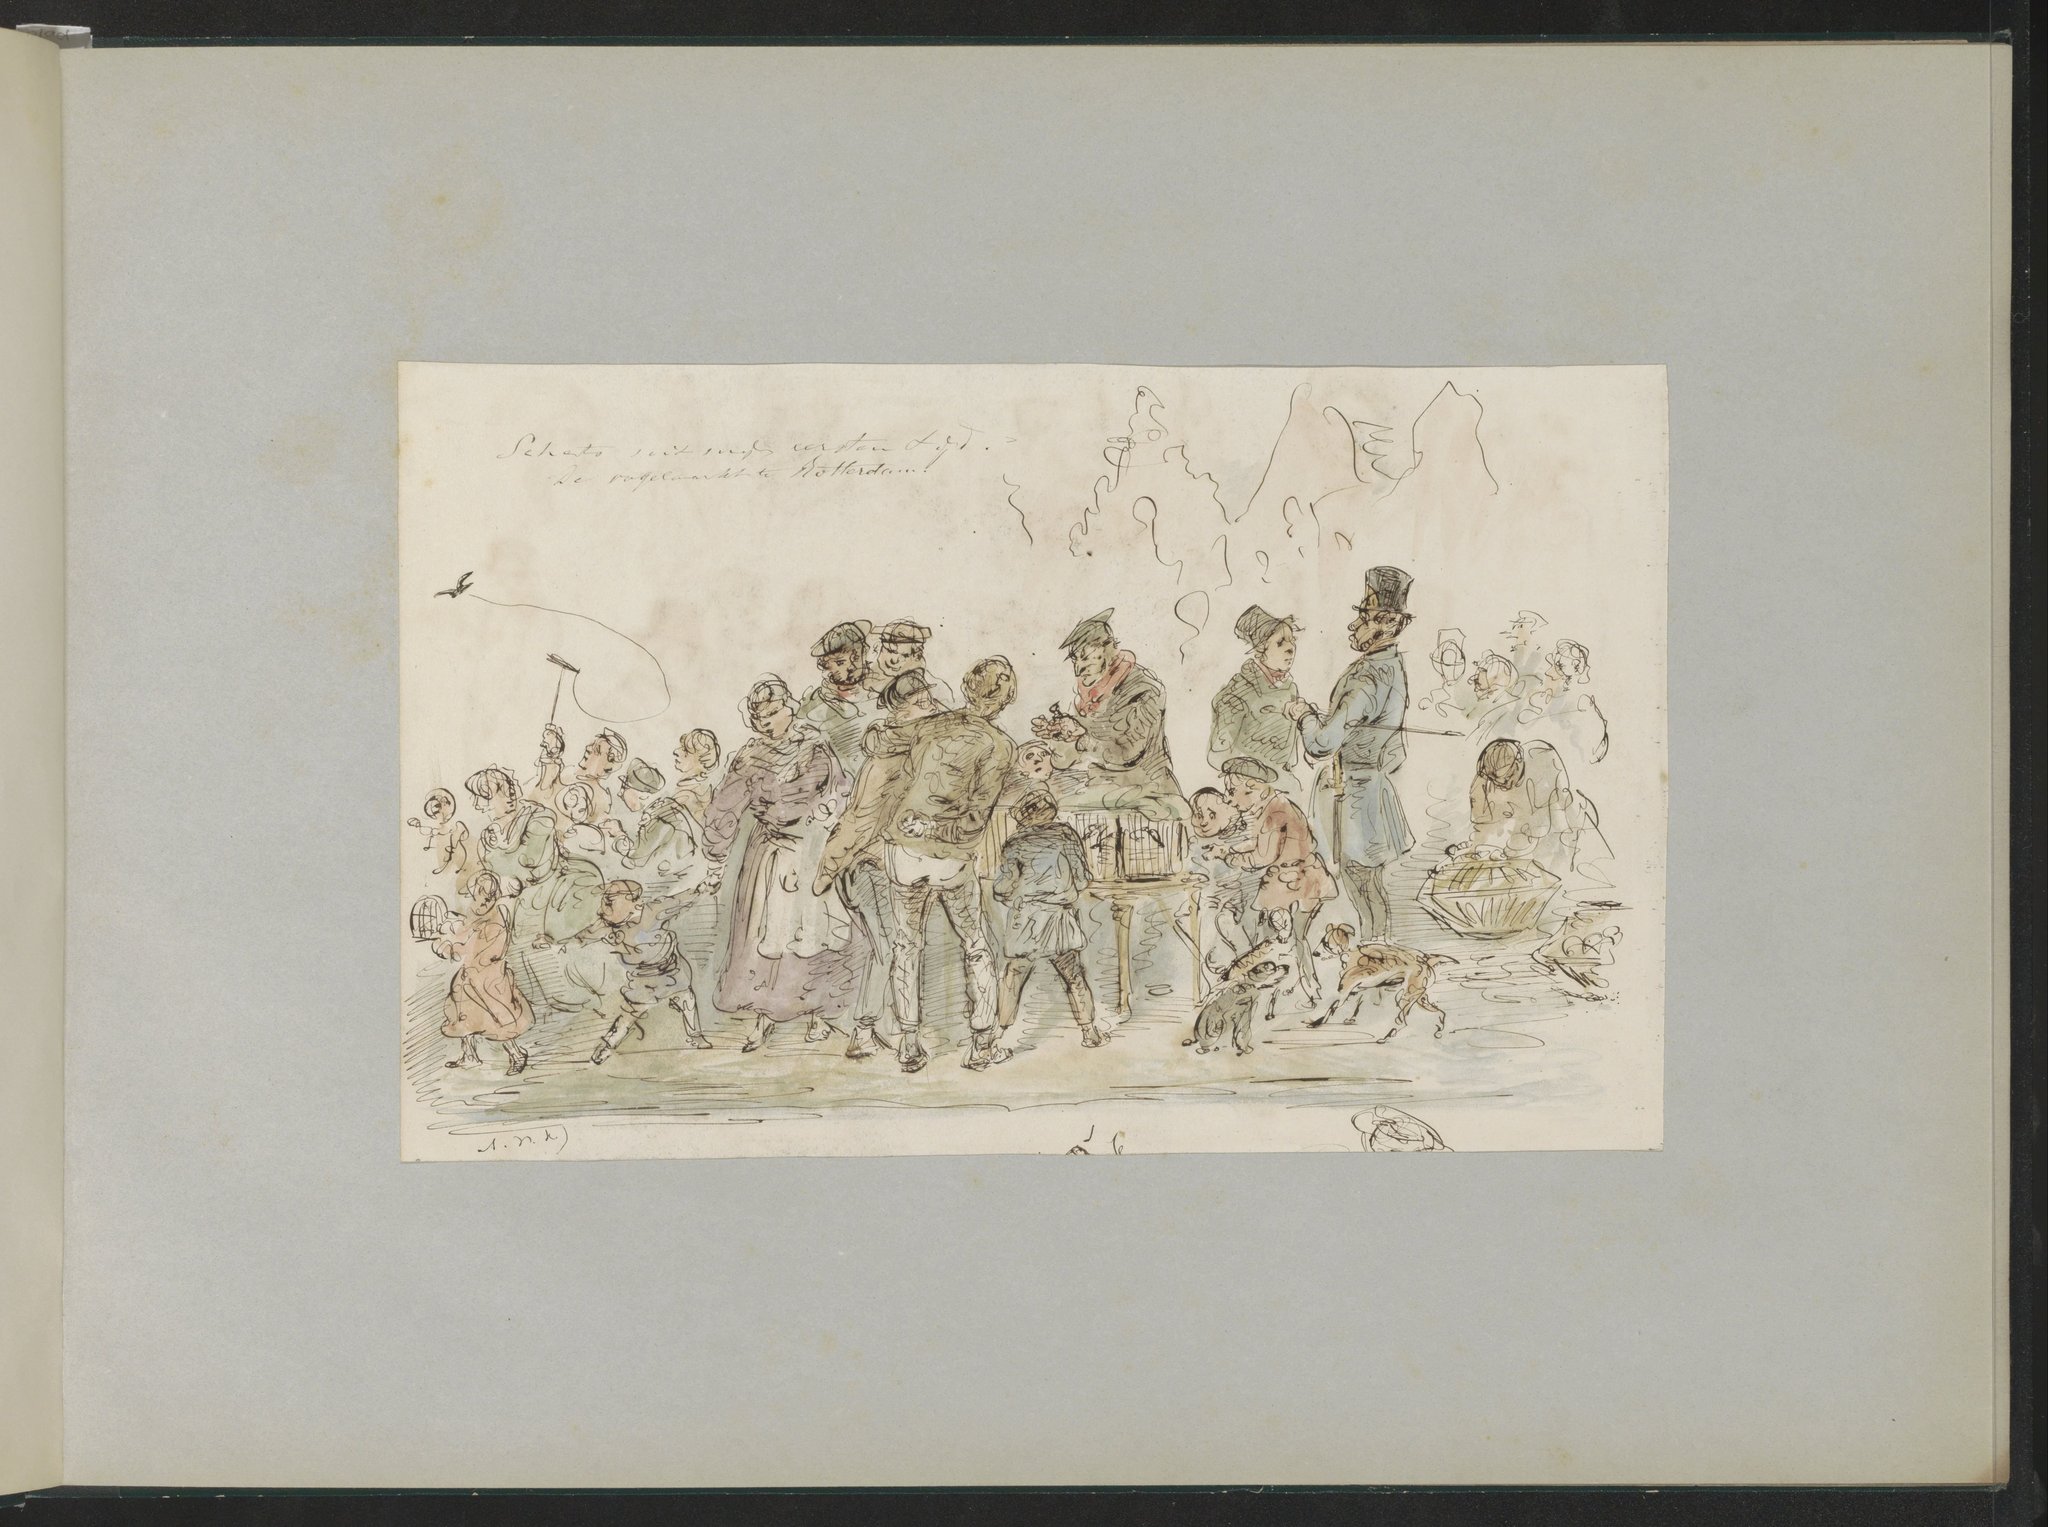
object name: album leaf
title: Vogelmarkt te Rotterdam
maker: alexander ver huell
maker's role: draughtsman, print maker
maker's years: 1822-1897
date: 1854-1887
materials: ink, paper, watercolor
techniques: brush, pen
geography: rotterdam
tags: birds, market, rotterdam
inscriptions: annotation: ‘Schets uit mijn eersten tijd./ De vogelmarkt te Rotterdam.’, signature: ‘A. V. h.’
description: Recto van de tekening op blad 1 van een album met 35 tekeningen.